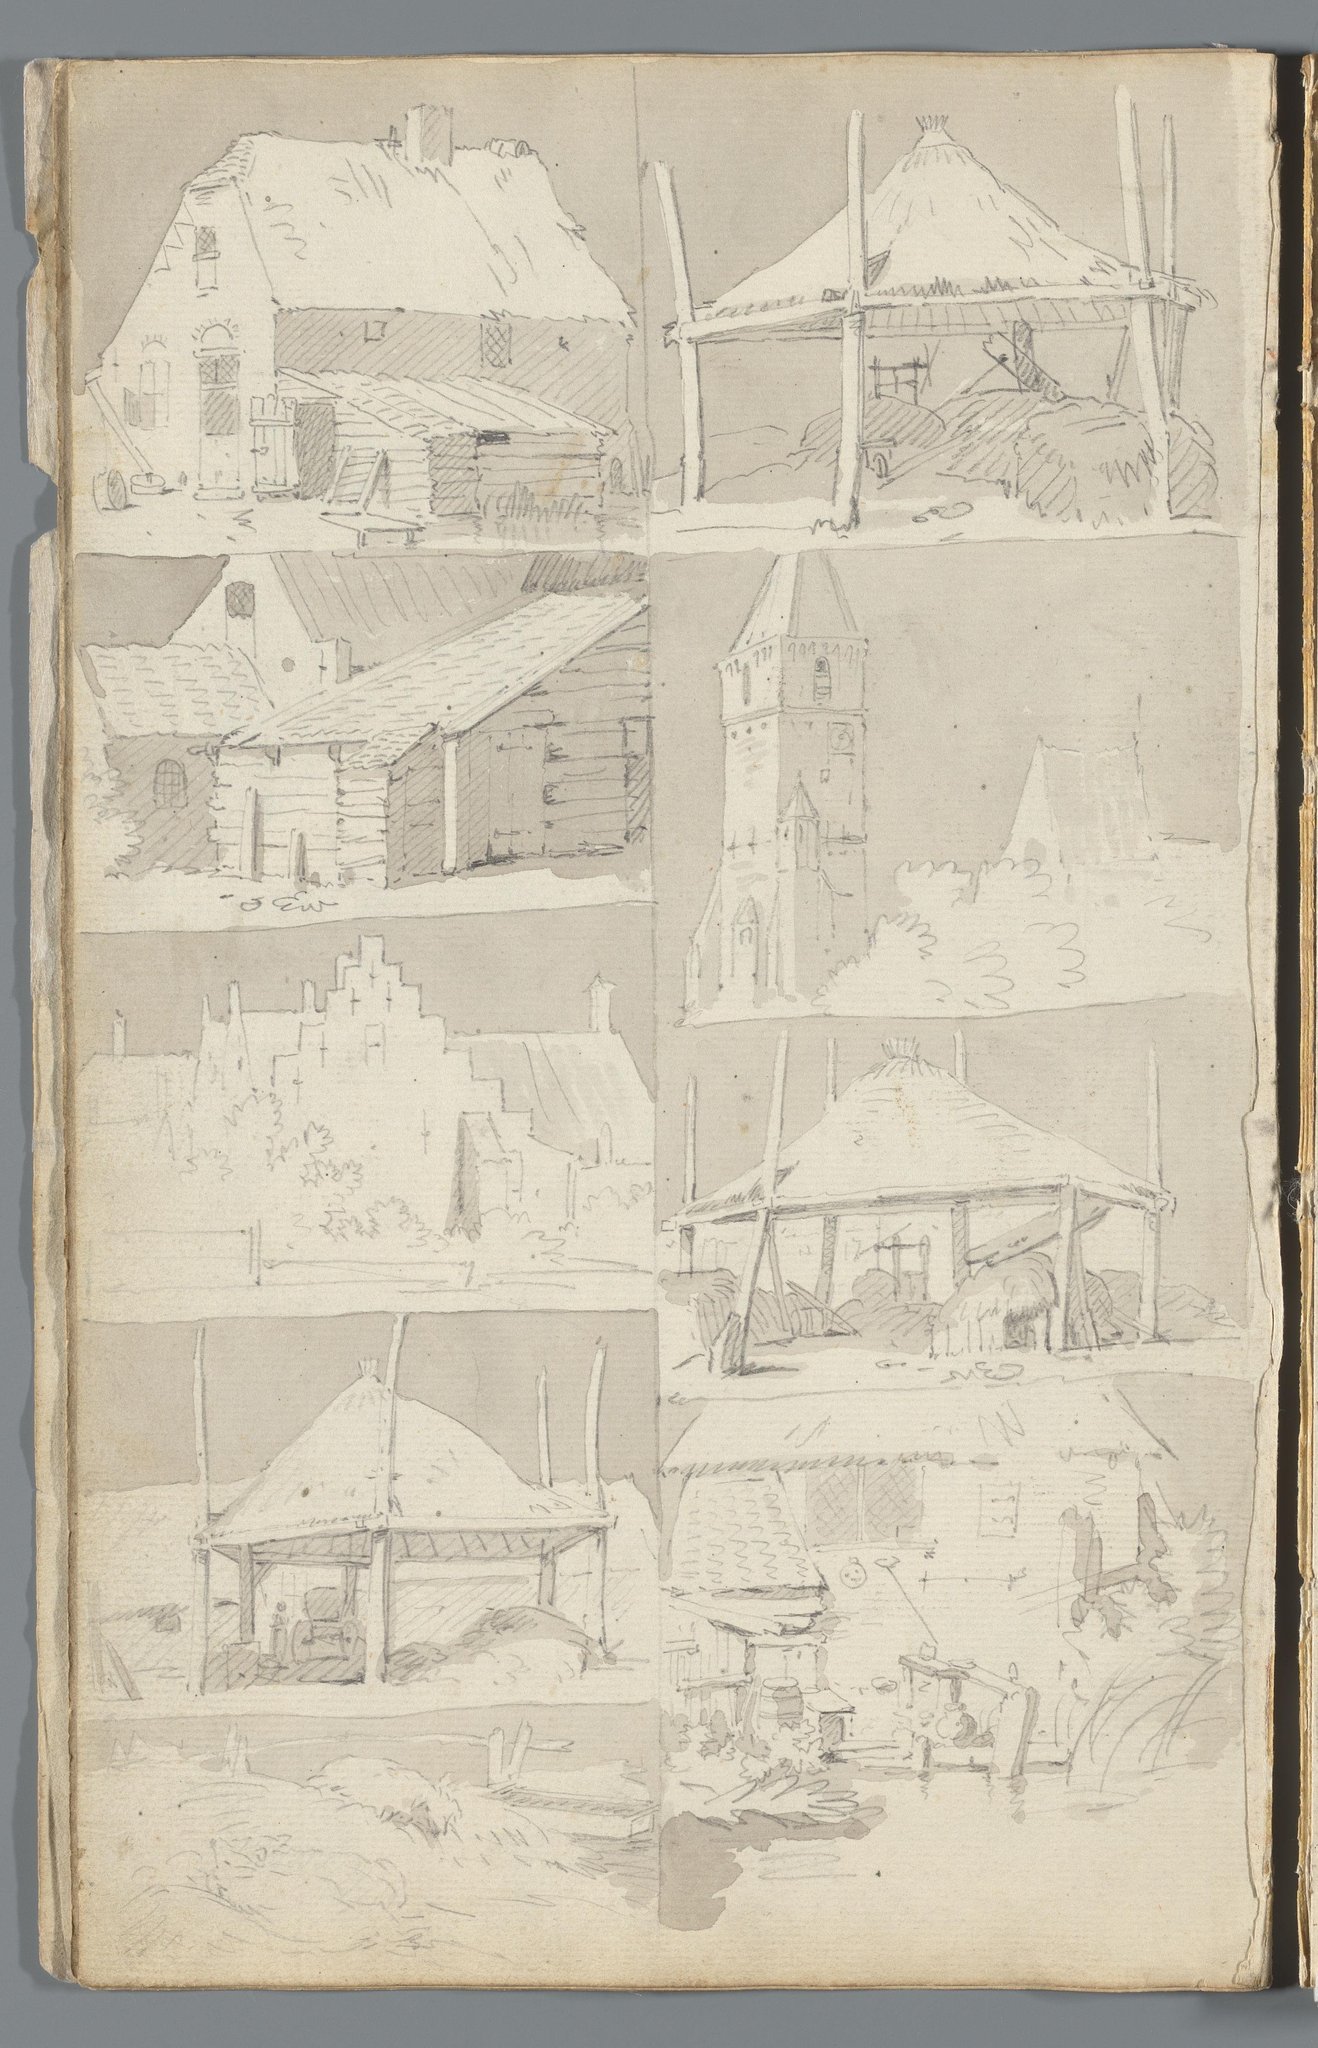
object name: sketchbook leaf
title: Boerderijen en hooimijten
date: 1780-1800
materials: ink, paper, pencil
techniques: brush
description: Blad 5 verso uit een schetsboek met 17 bladen.